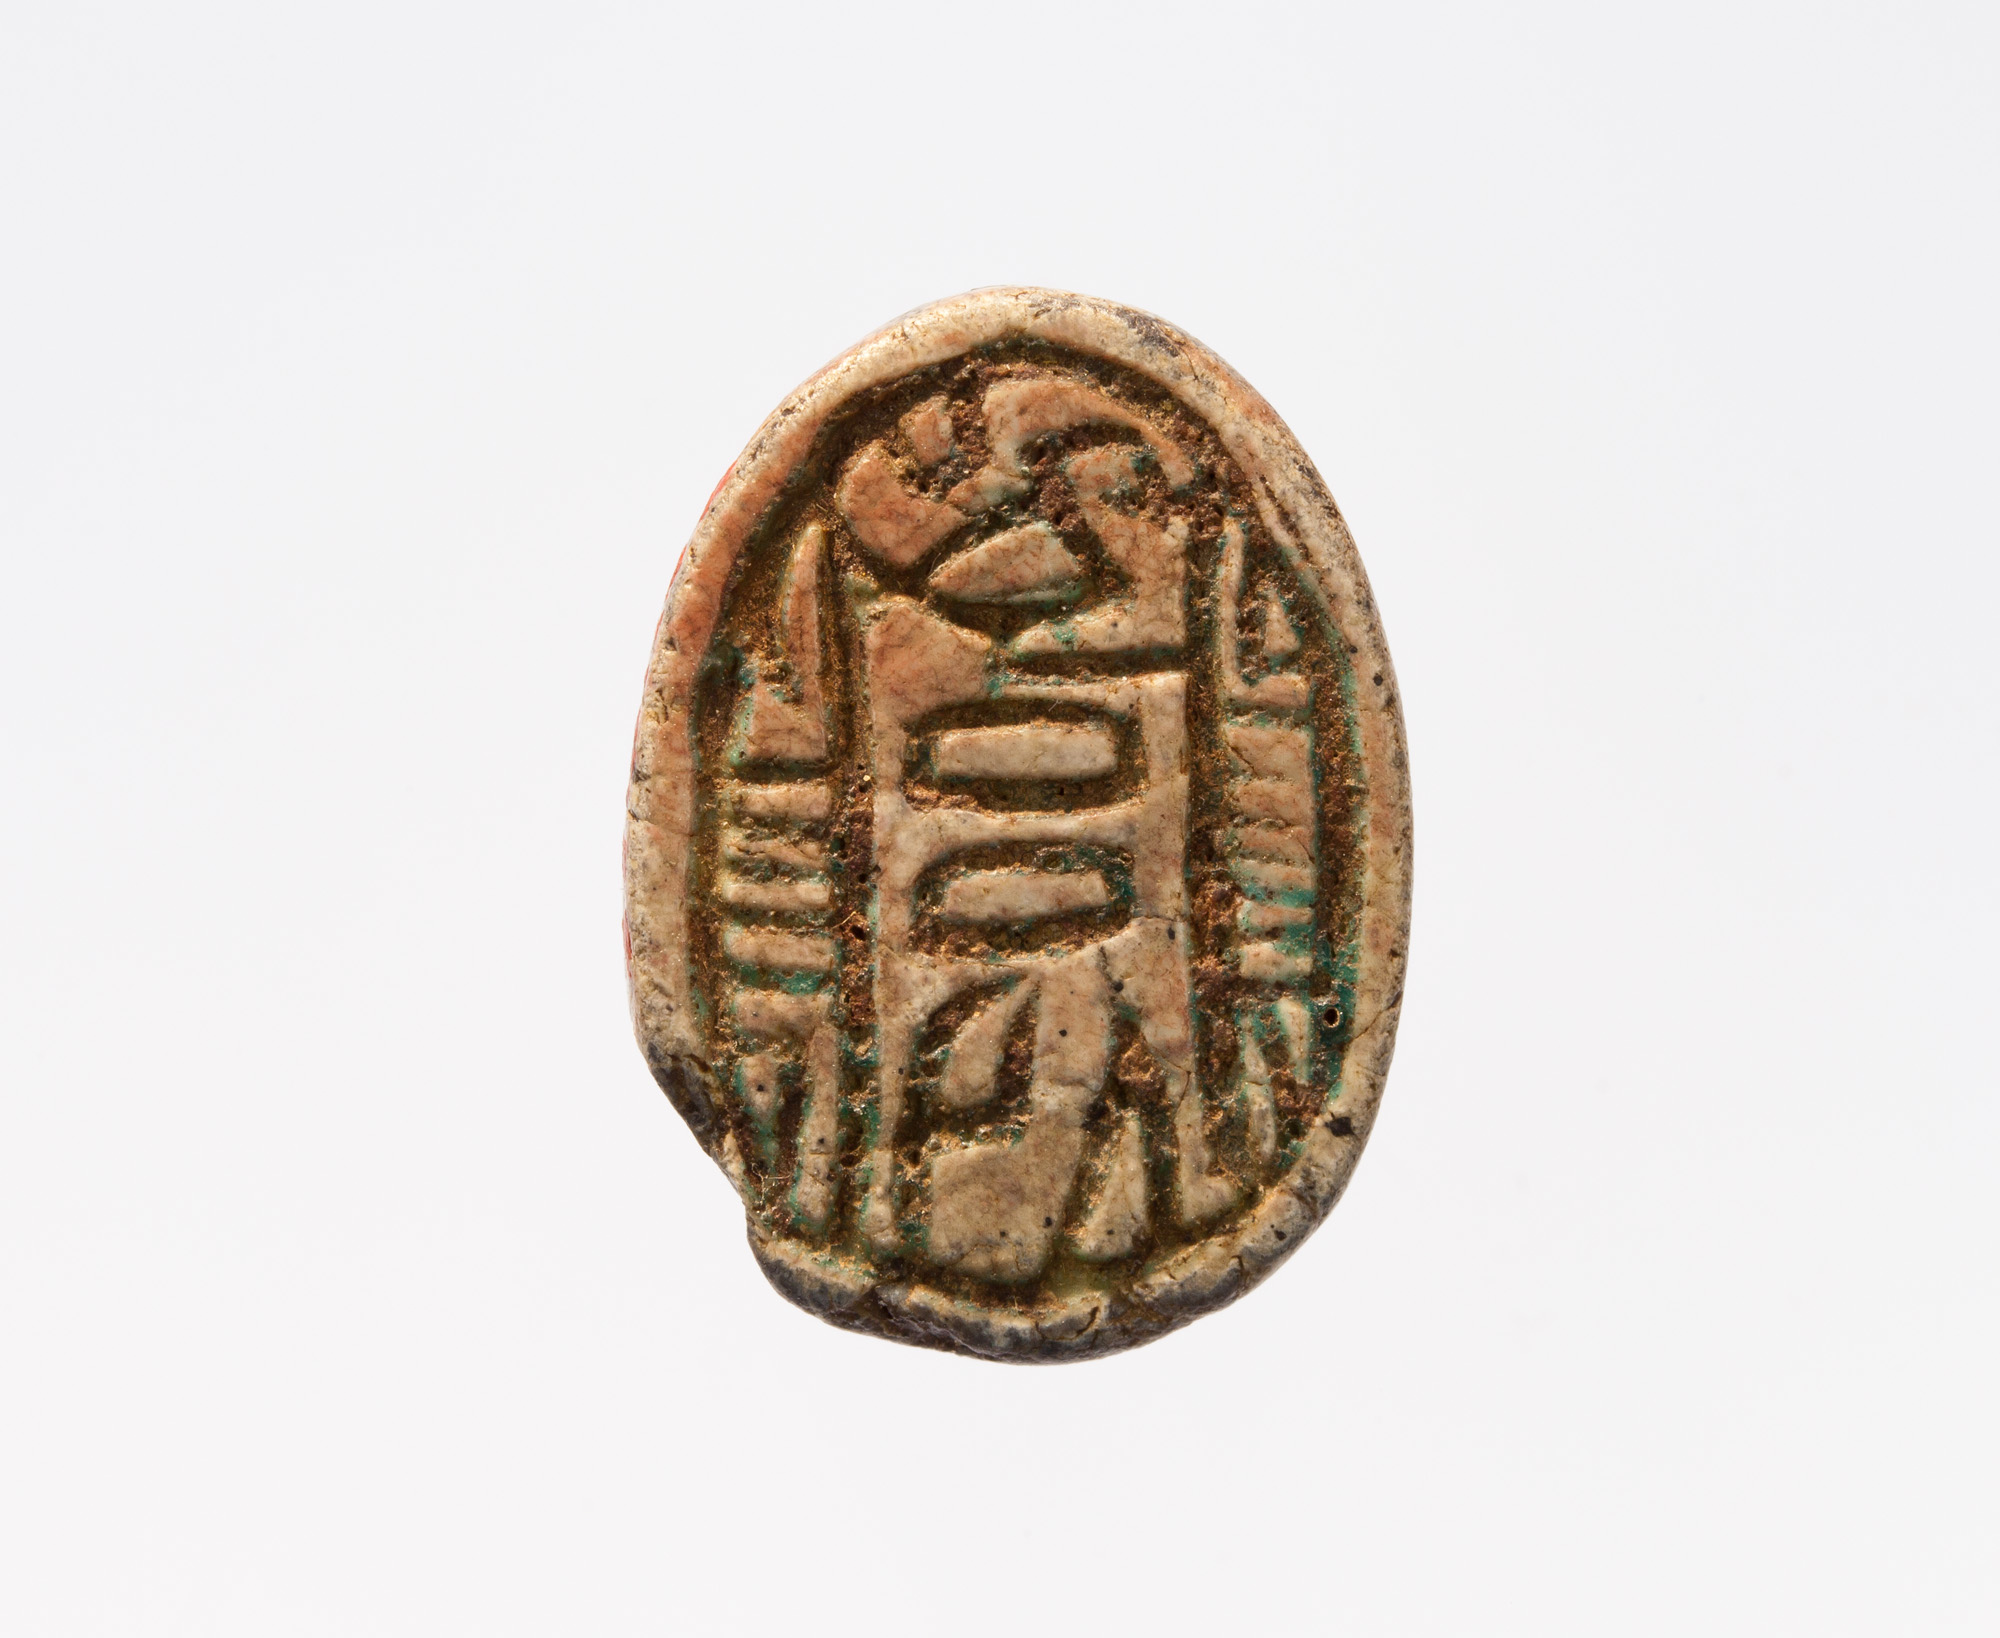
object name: scarab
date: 1479-1458 BCE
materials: faience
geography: egypt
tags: hieroglyphs,scarabs